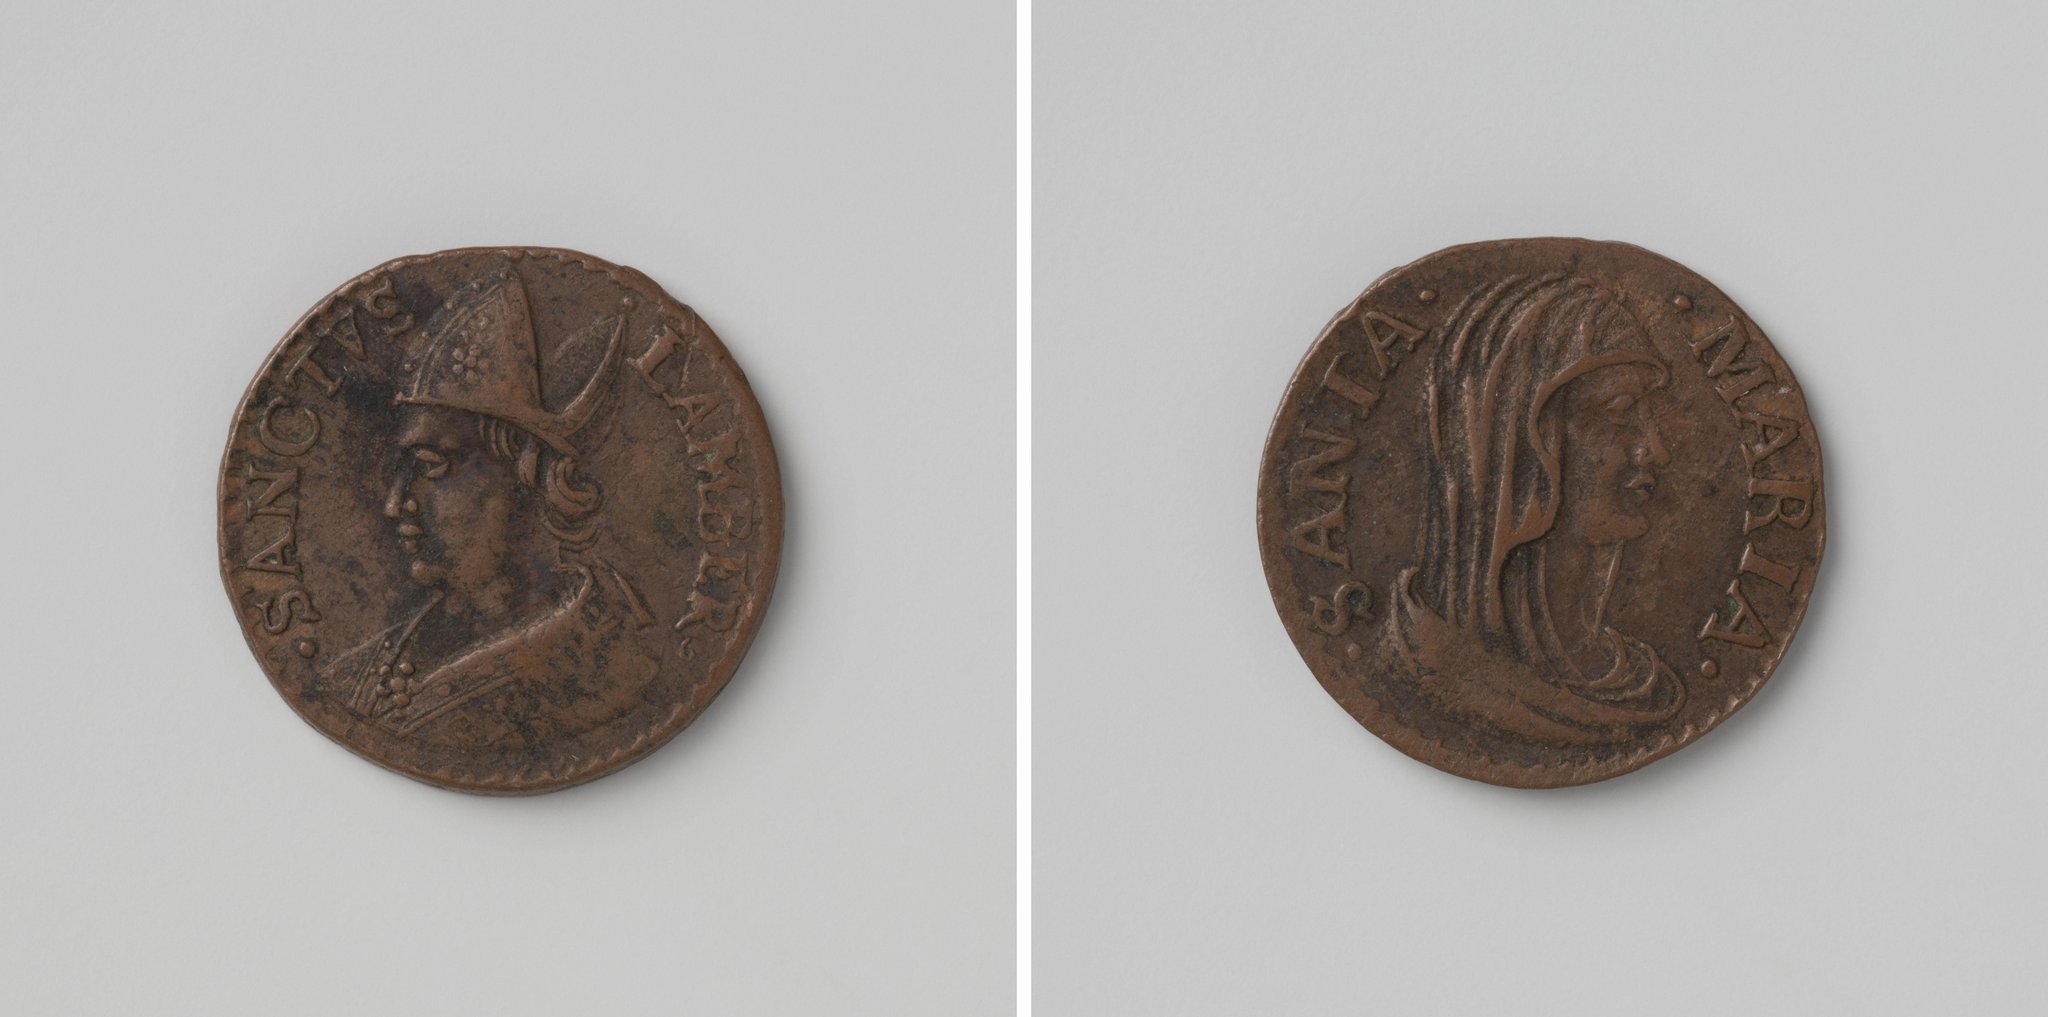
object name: devotional medal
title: Sint Lambertus en Maria, Sint-Lambertuskathedraal, Luik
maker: Anonymous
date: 1600-1800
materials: copper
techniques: striking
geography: liège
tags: sint-lambertuskathedraal (luik)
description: Koperen penning. Voorzijde: naar links gewende, gemijterde Sint Lambertus binnen omschrift. Keerzijde: naar rechts gewende, gesluierde Maria binnen omschrift